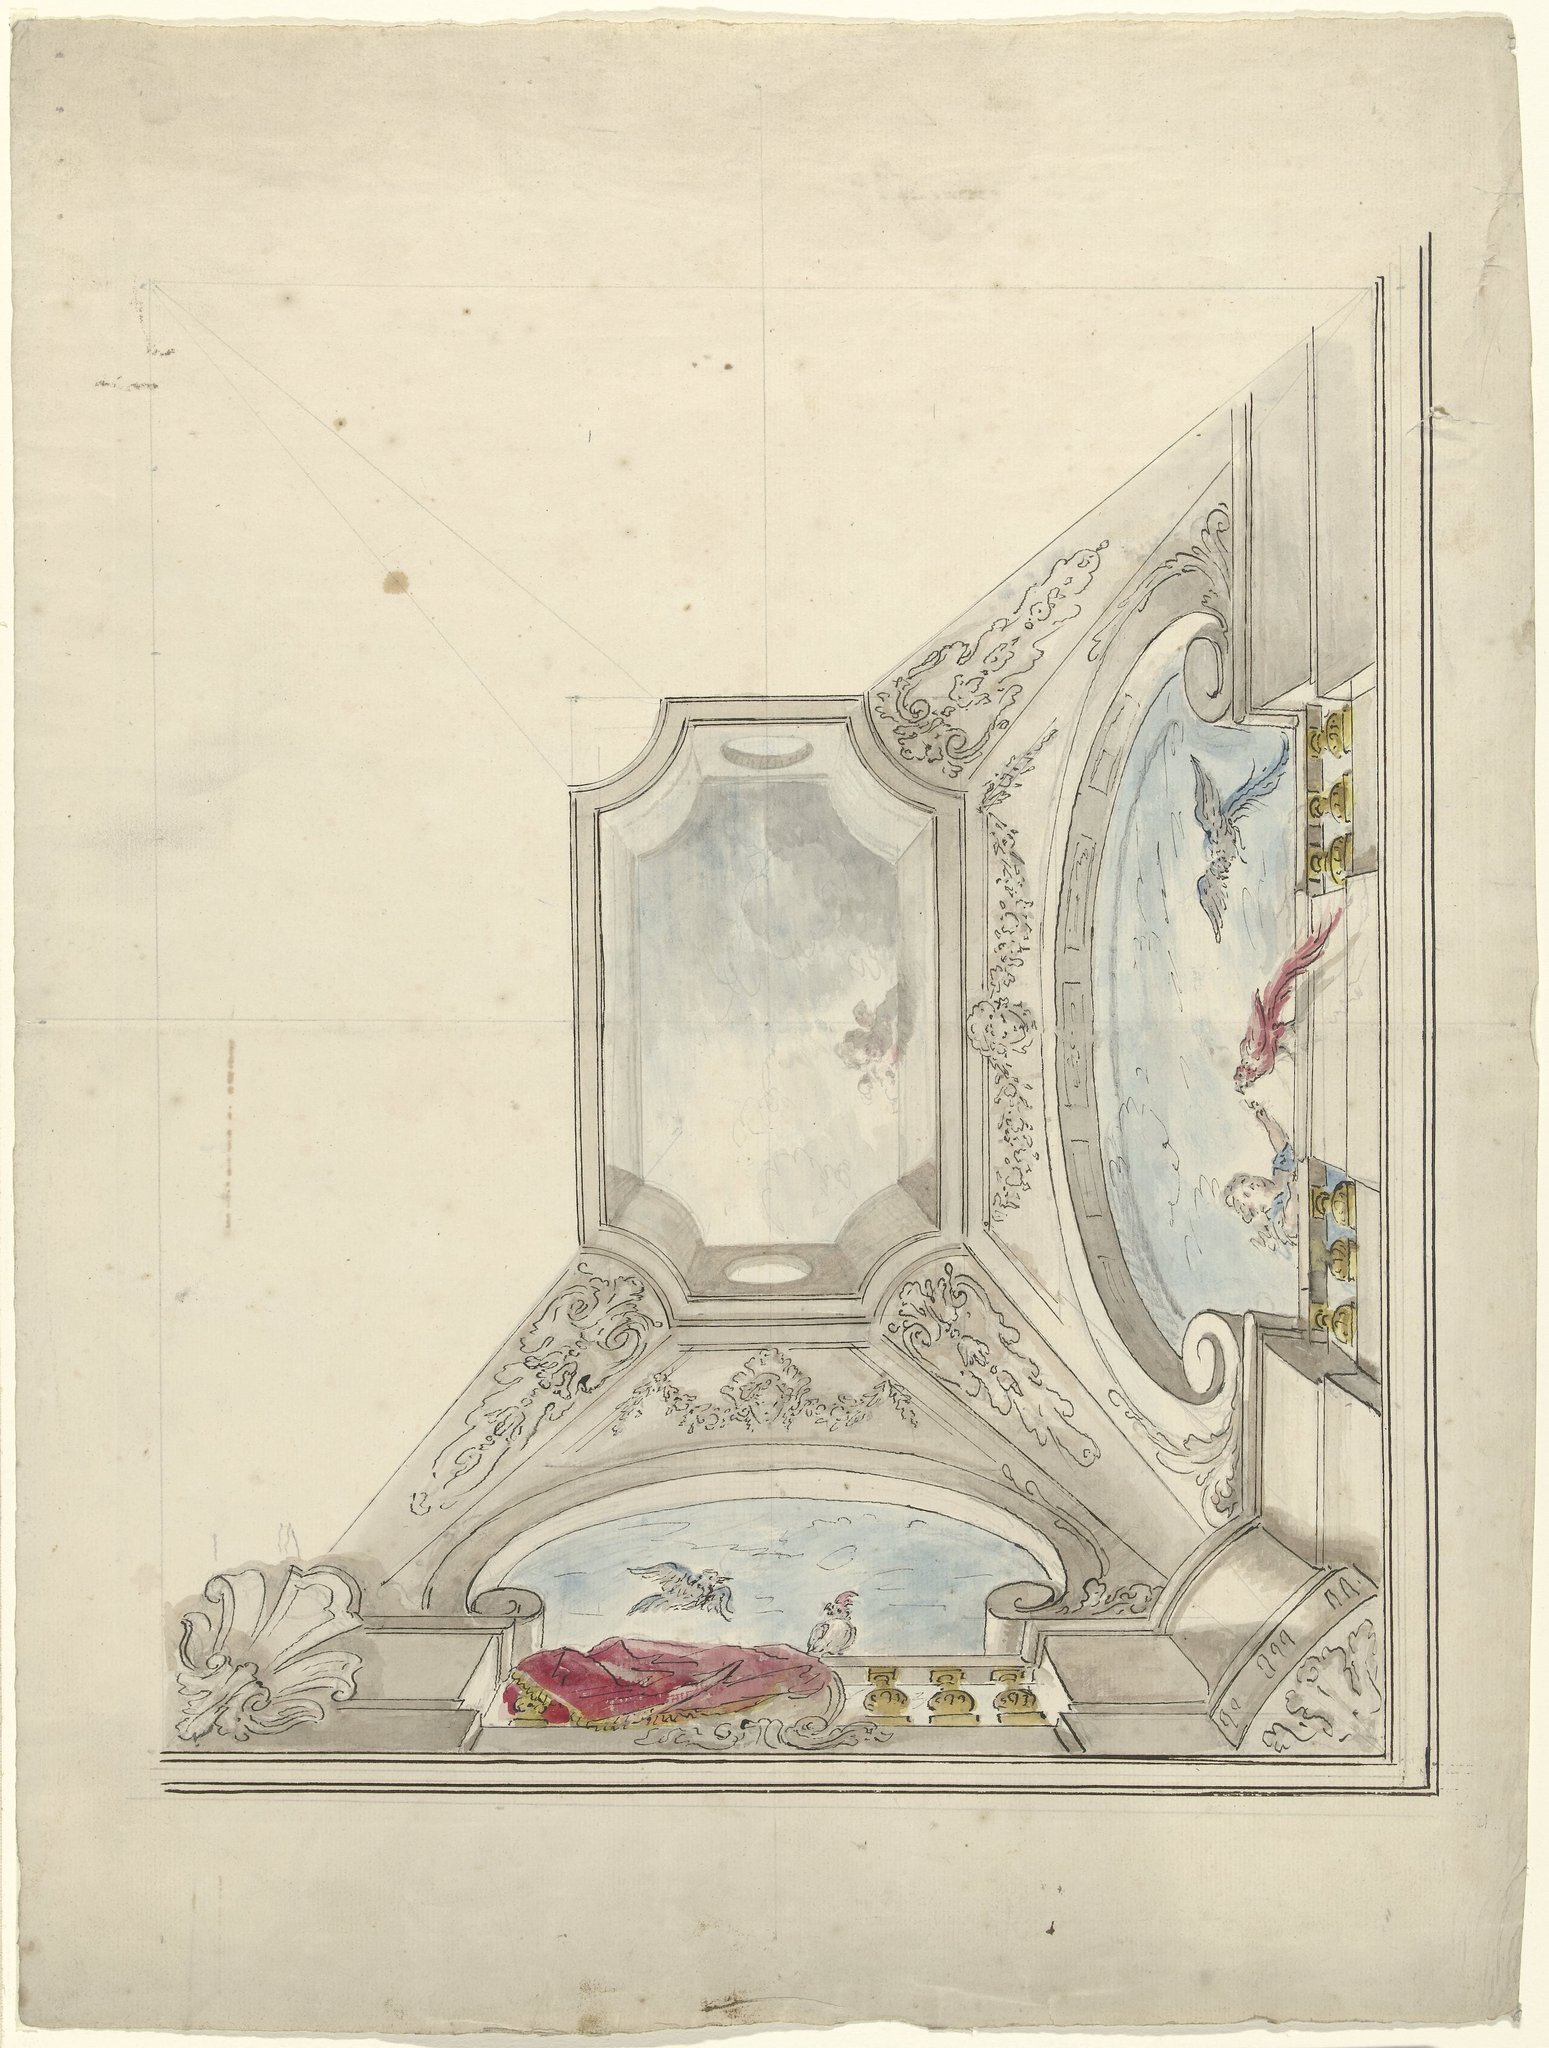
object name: drawing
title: Ontwerp voor een plafondschildering met doorbroken gewelf met uitzicht naar de lucht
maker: dionys van nijmegen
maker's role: draughtsman, painter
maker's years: 1705-1798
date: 1715-1798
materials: ink, paper, pencil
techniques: brush, pen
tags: (decorated) ceiling